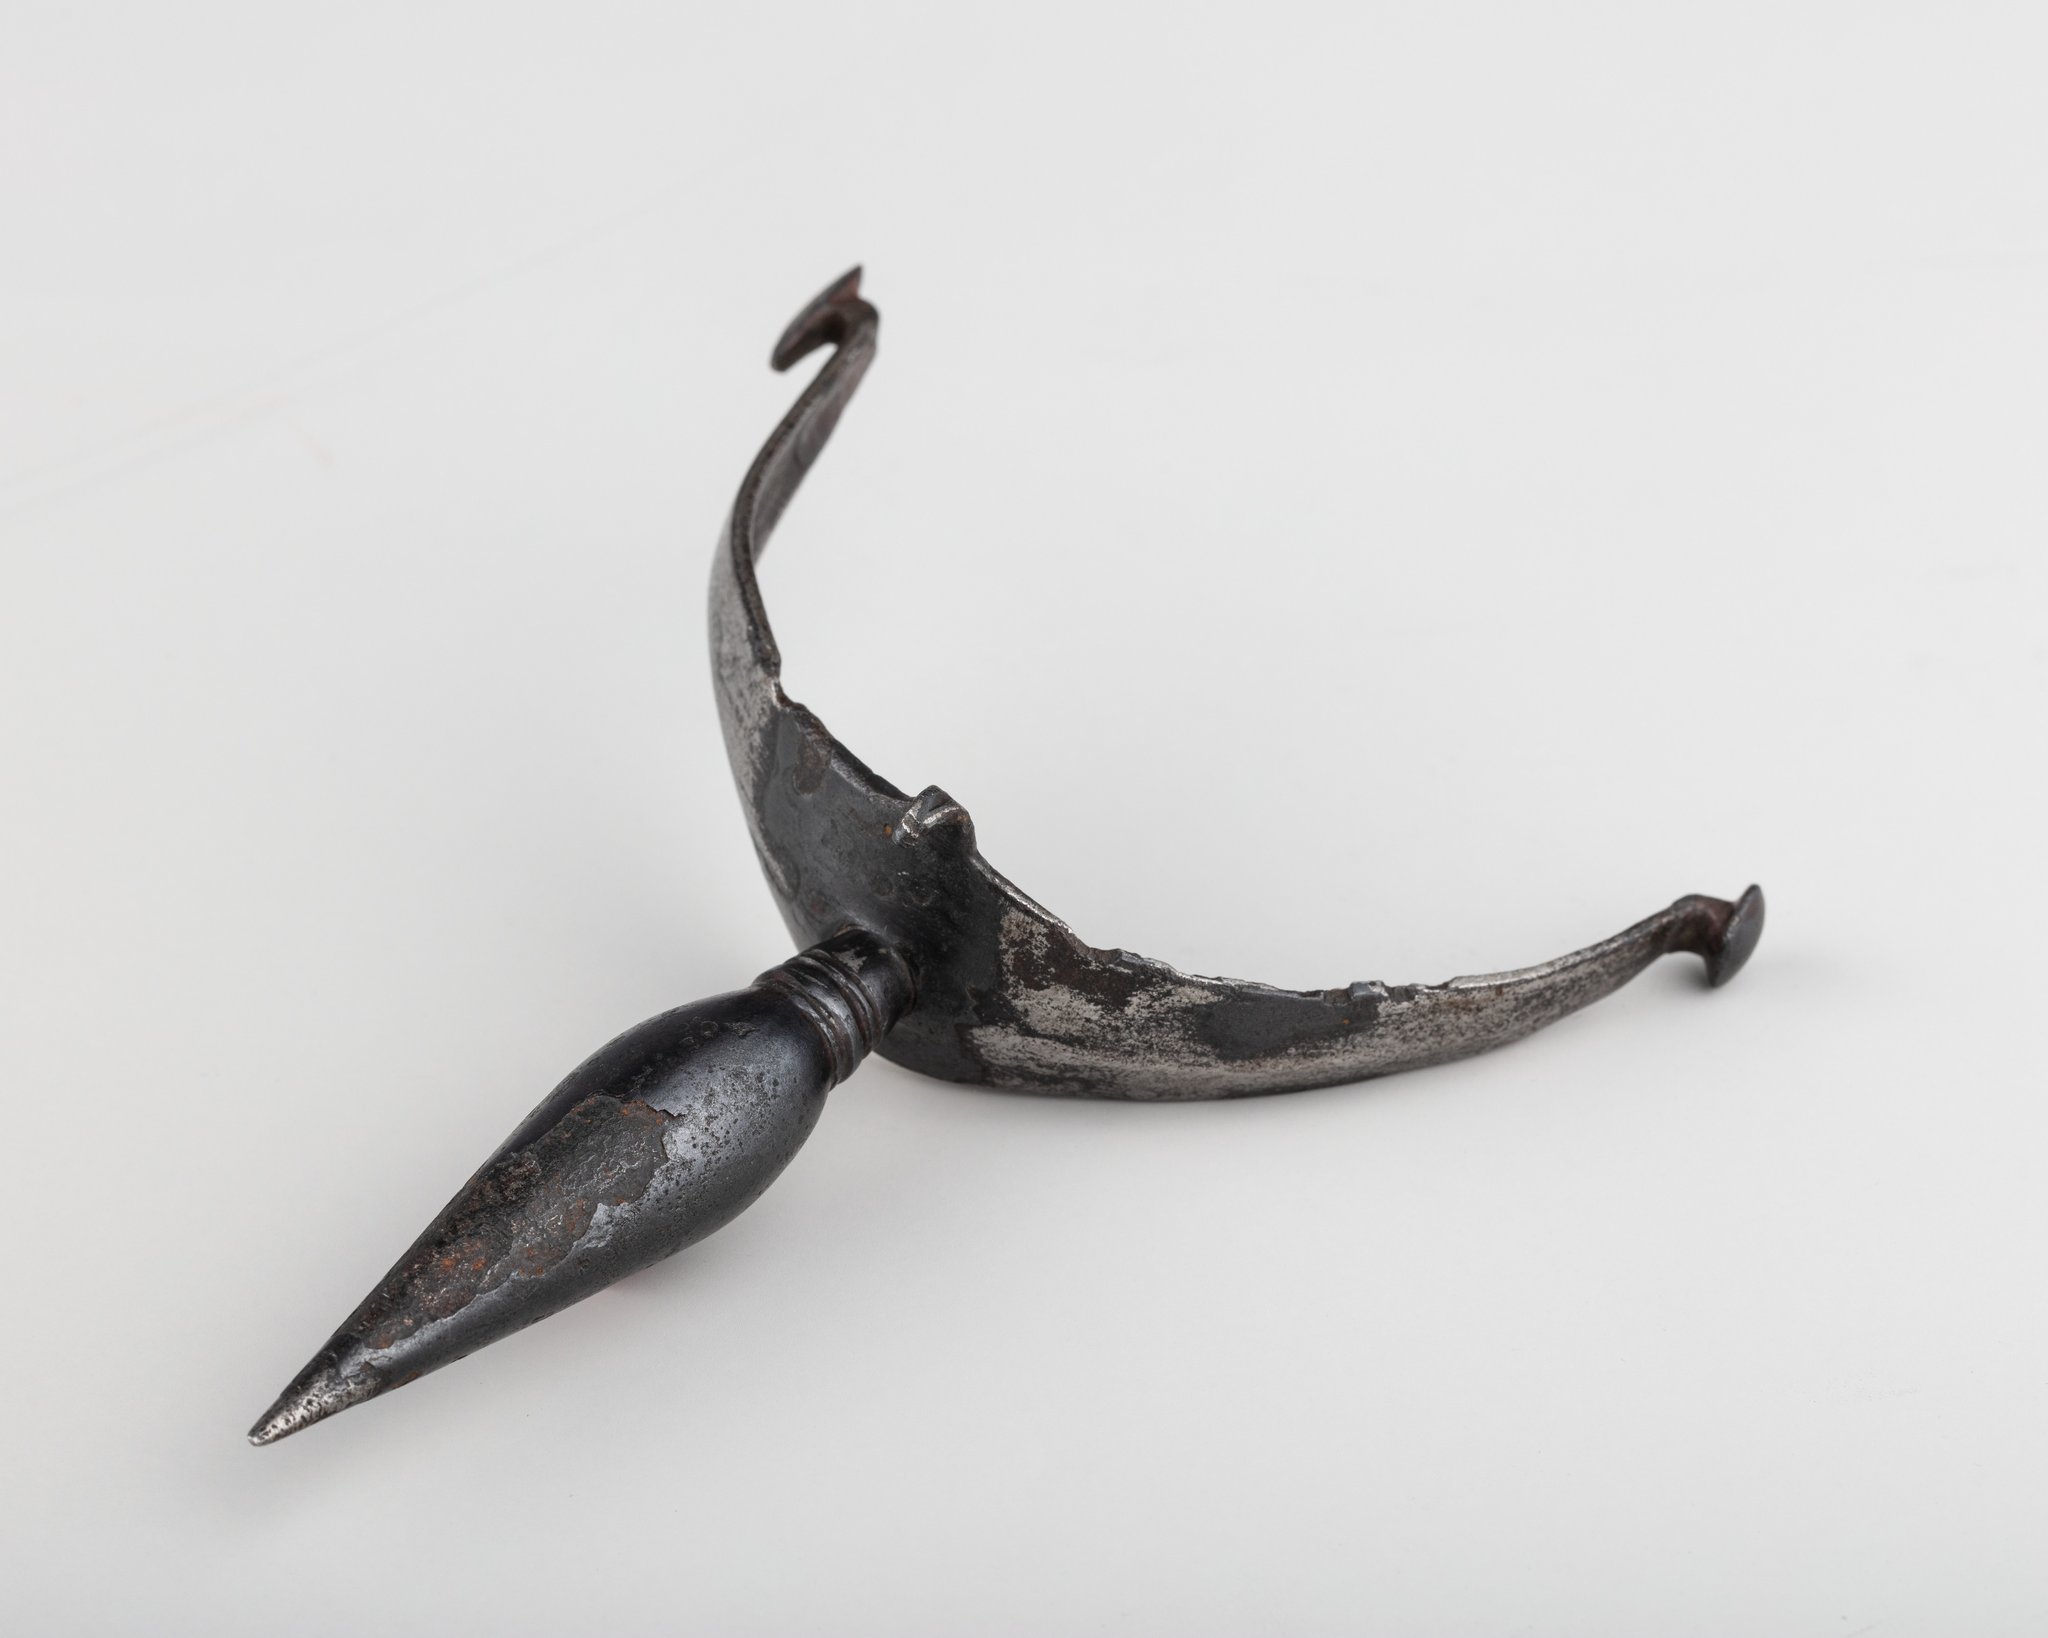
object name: spur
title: Prick Spur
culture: germanic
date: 101-300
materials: metal alloy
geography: germany